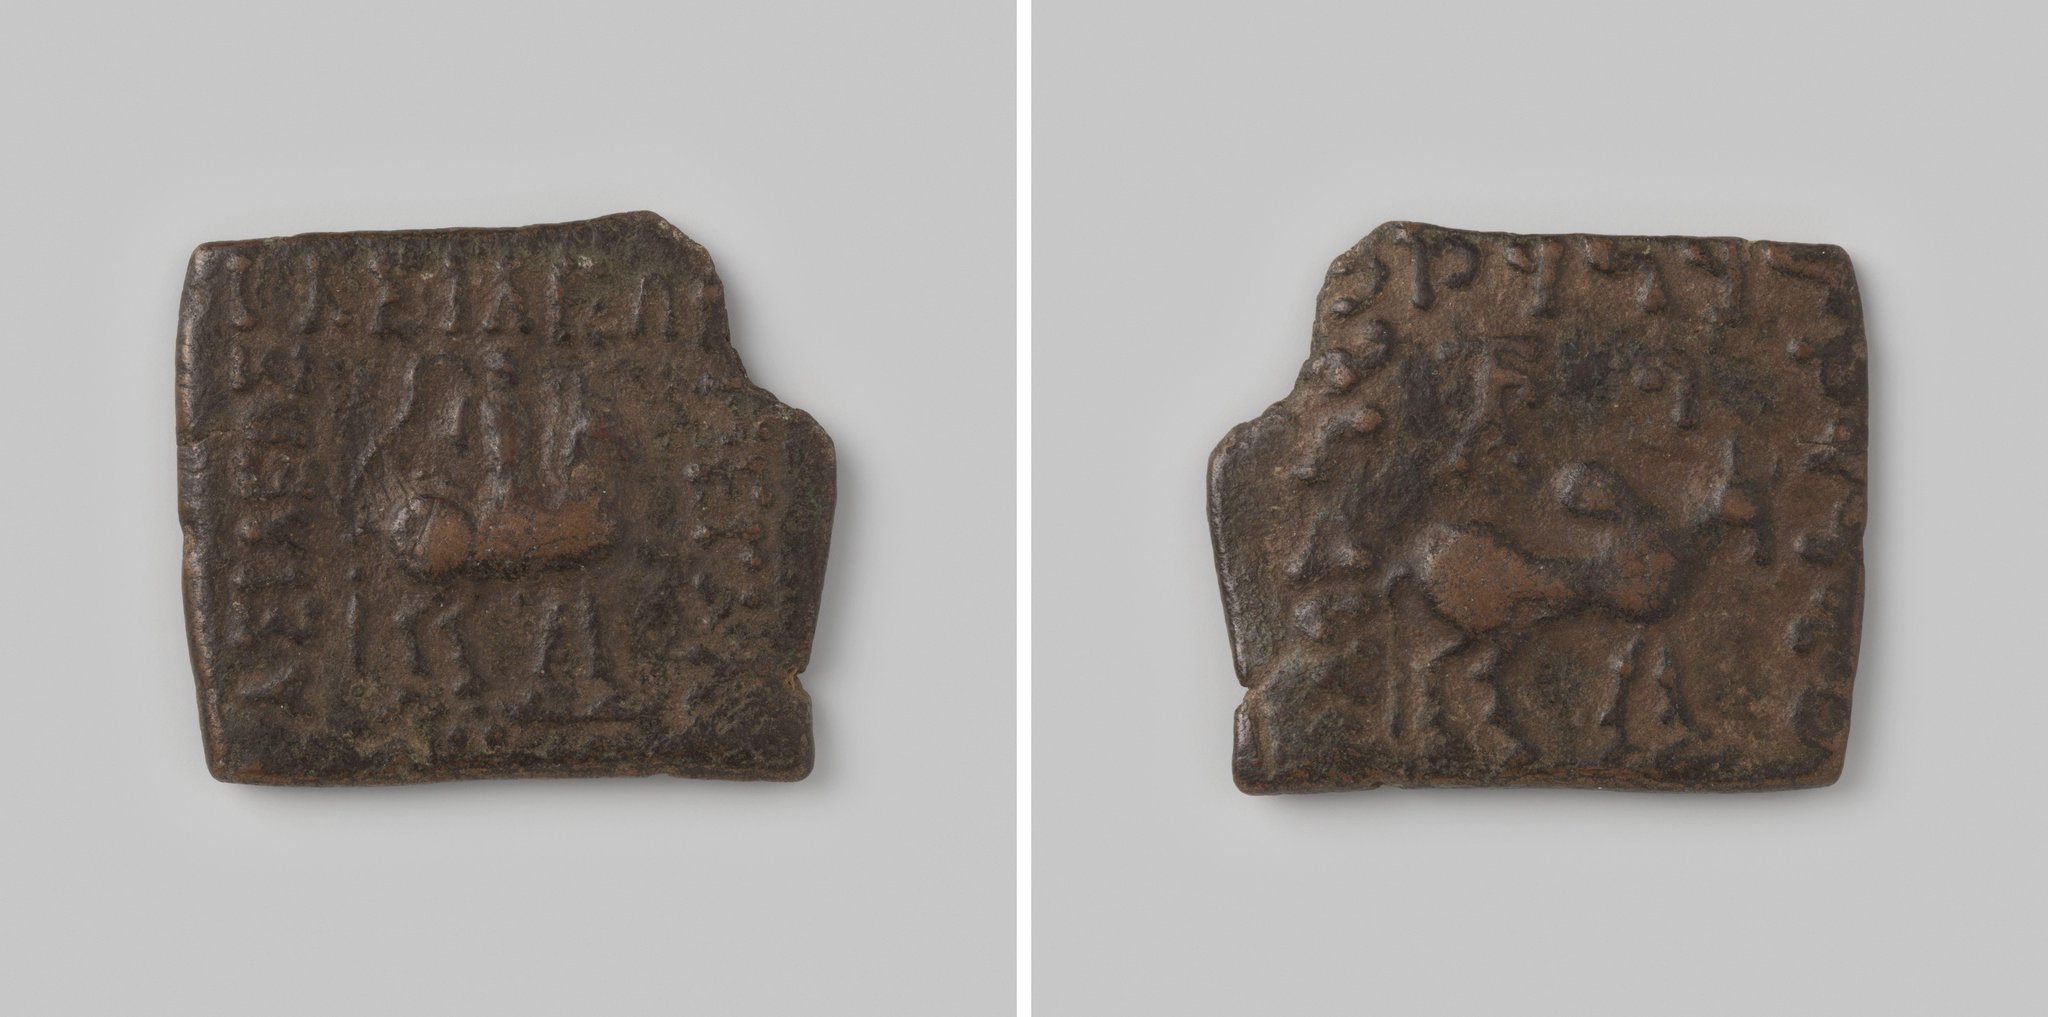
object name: coin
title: Munt uit Bactrië van koning Azes, -15 - 15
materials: copper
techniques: striking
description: Bronzen, rechthoekige munt. Voorzijde: de koning met lans te paard naar rechts. Grieks omschrift. Keerzijde: geboggelde stier. Omschrift in Pali.